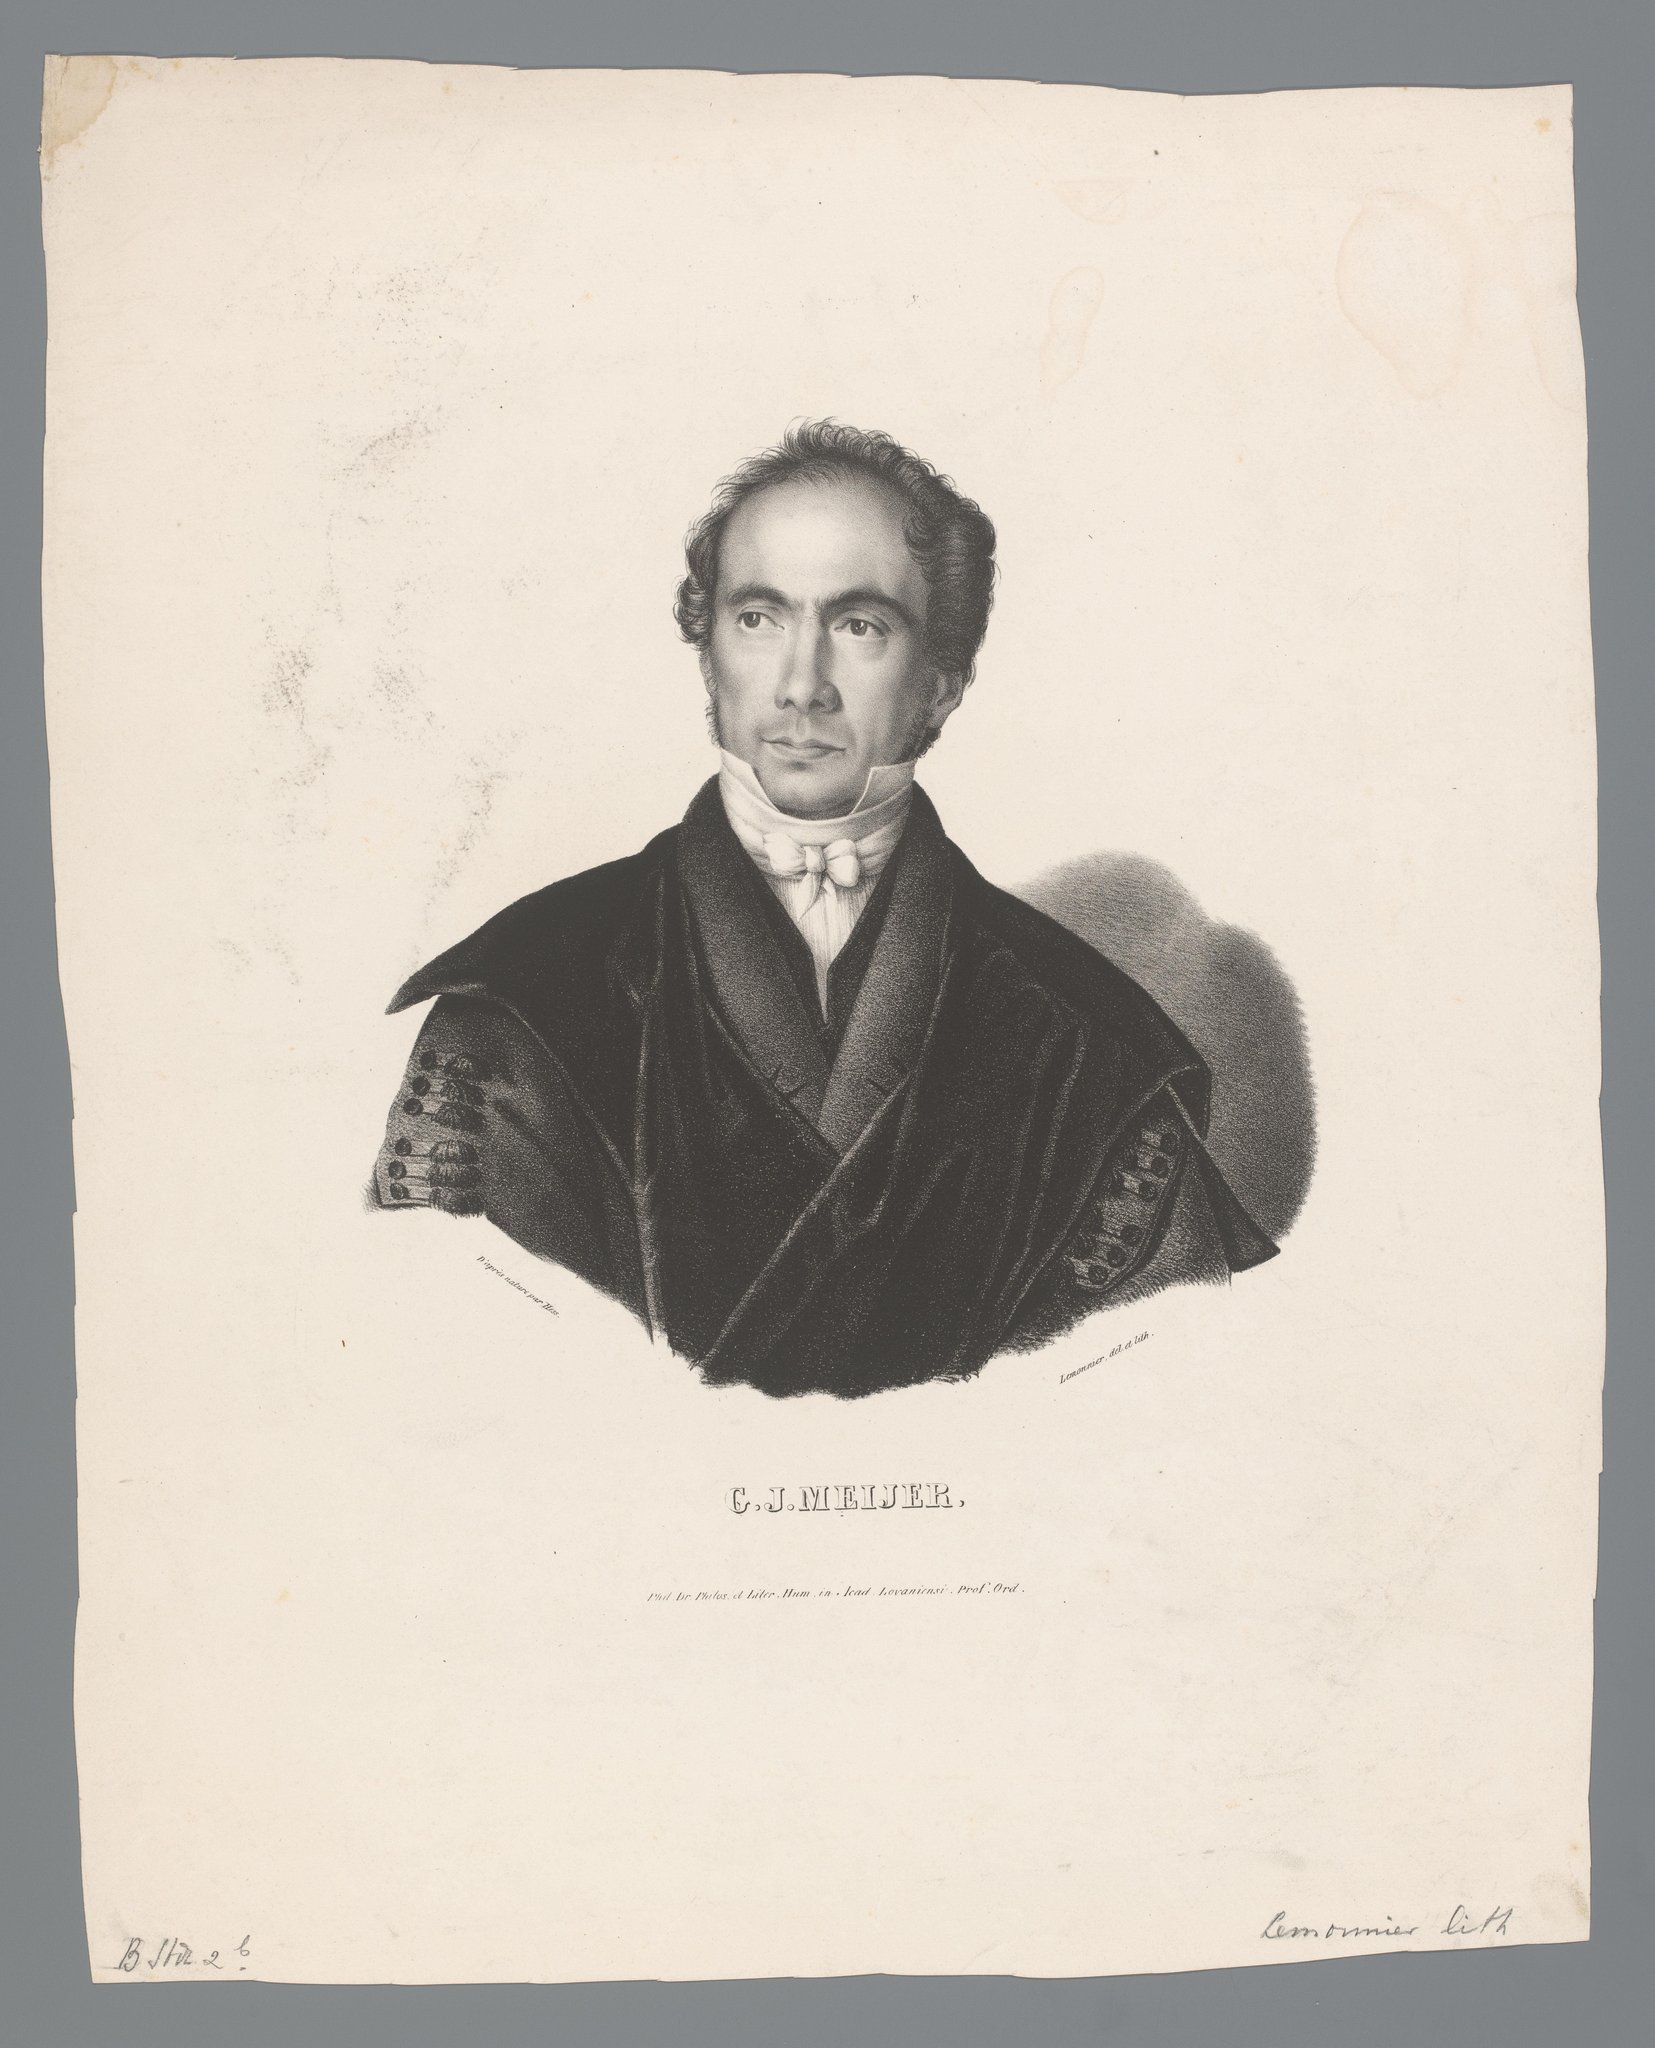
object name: print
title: G.J. Meijer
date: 1823-1841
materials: paper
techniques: lithograph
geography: brussels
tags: adult man, historical persons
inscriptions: collector's mark: Lugt 2228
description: Prent mogelijk verschenen in: Hess, Marcel. Iconographie des professeurs des universites des Pays-Bas. Brussel: Van Someren, 1827.